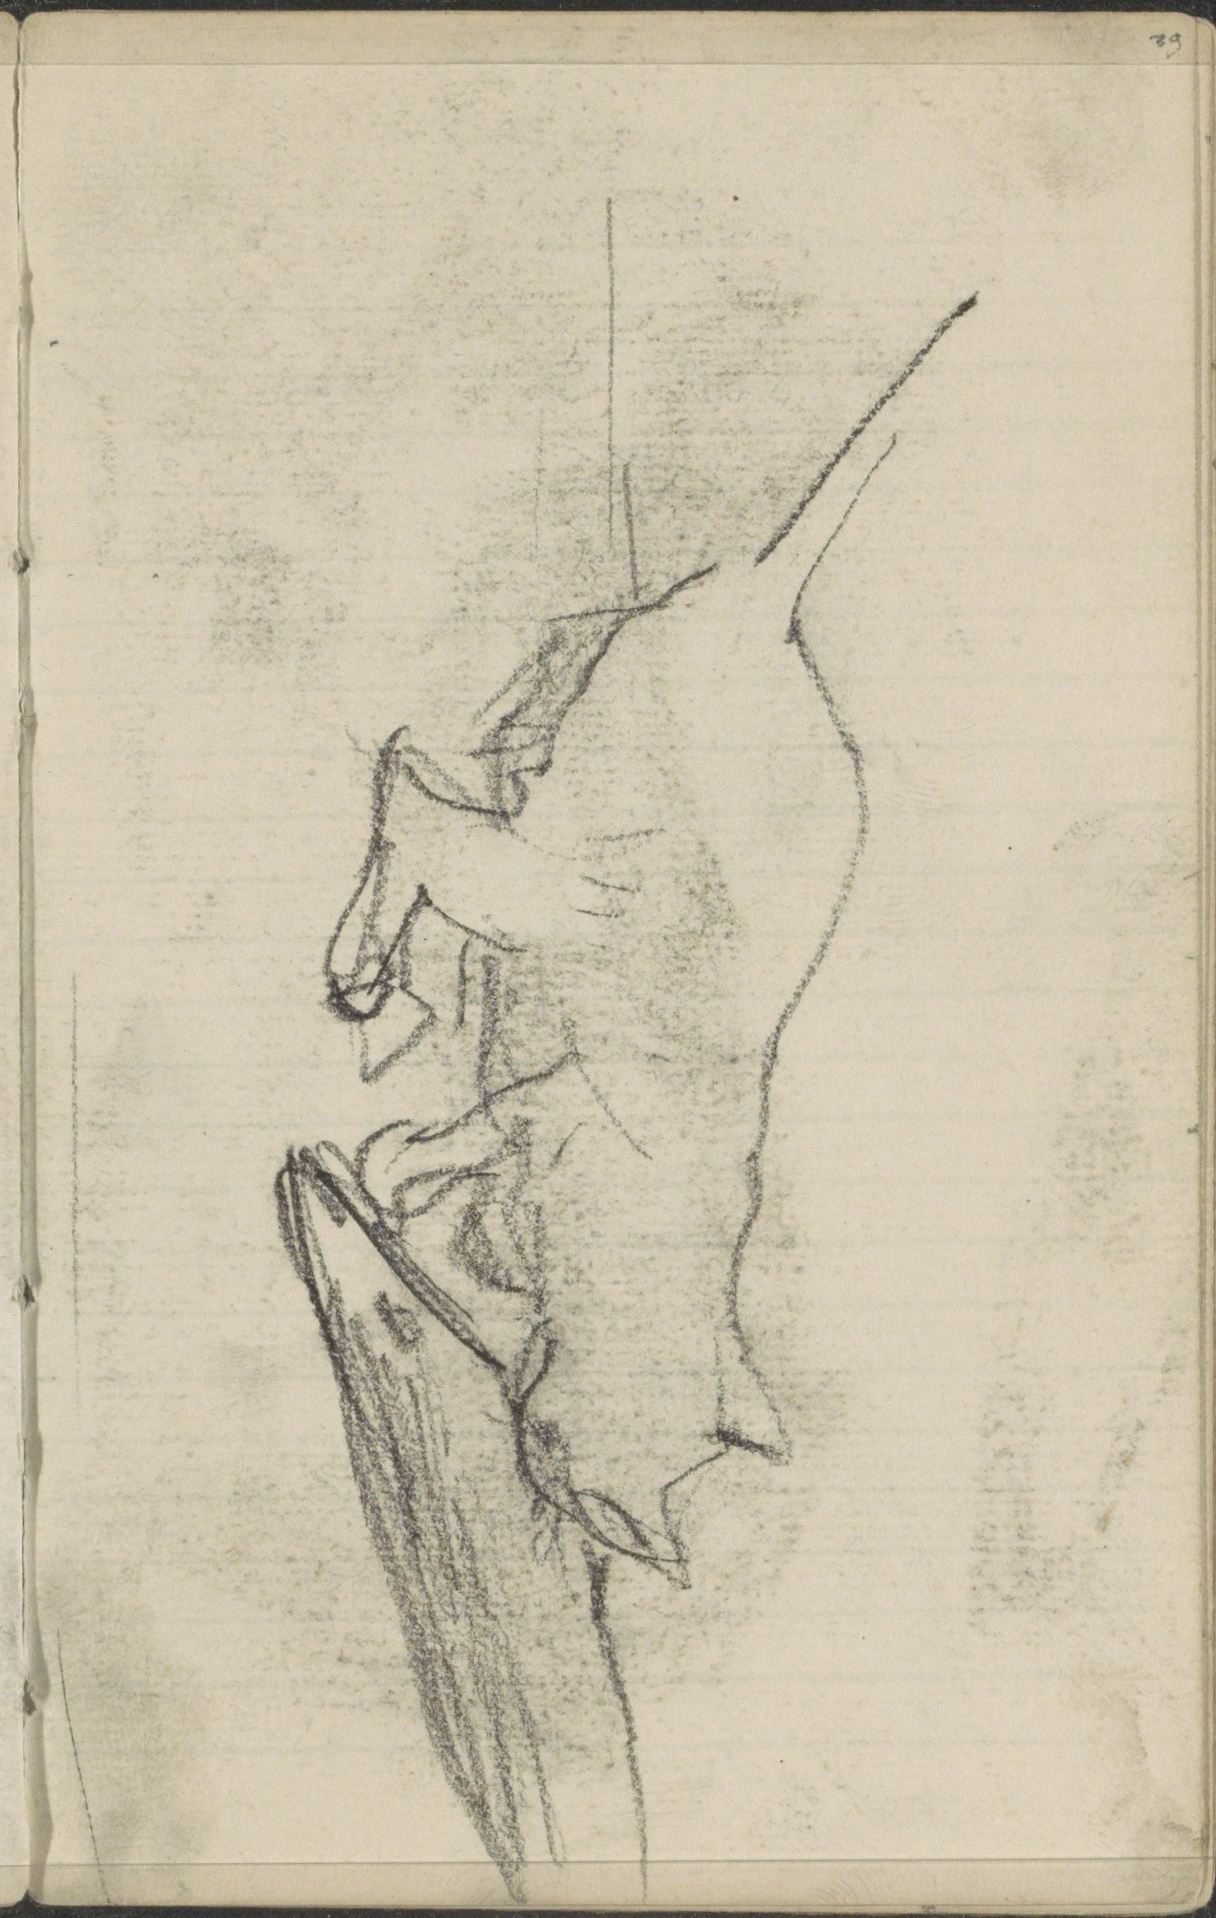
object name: sketchbook leaf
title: Kat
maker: marius bauer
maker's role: draughtsman, print maker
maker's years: 1867-1932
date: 1881-1885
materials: chalk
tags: cat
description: Pagina 39 uit een schetsboek met 26 bladen.